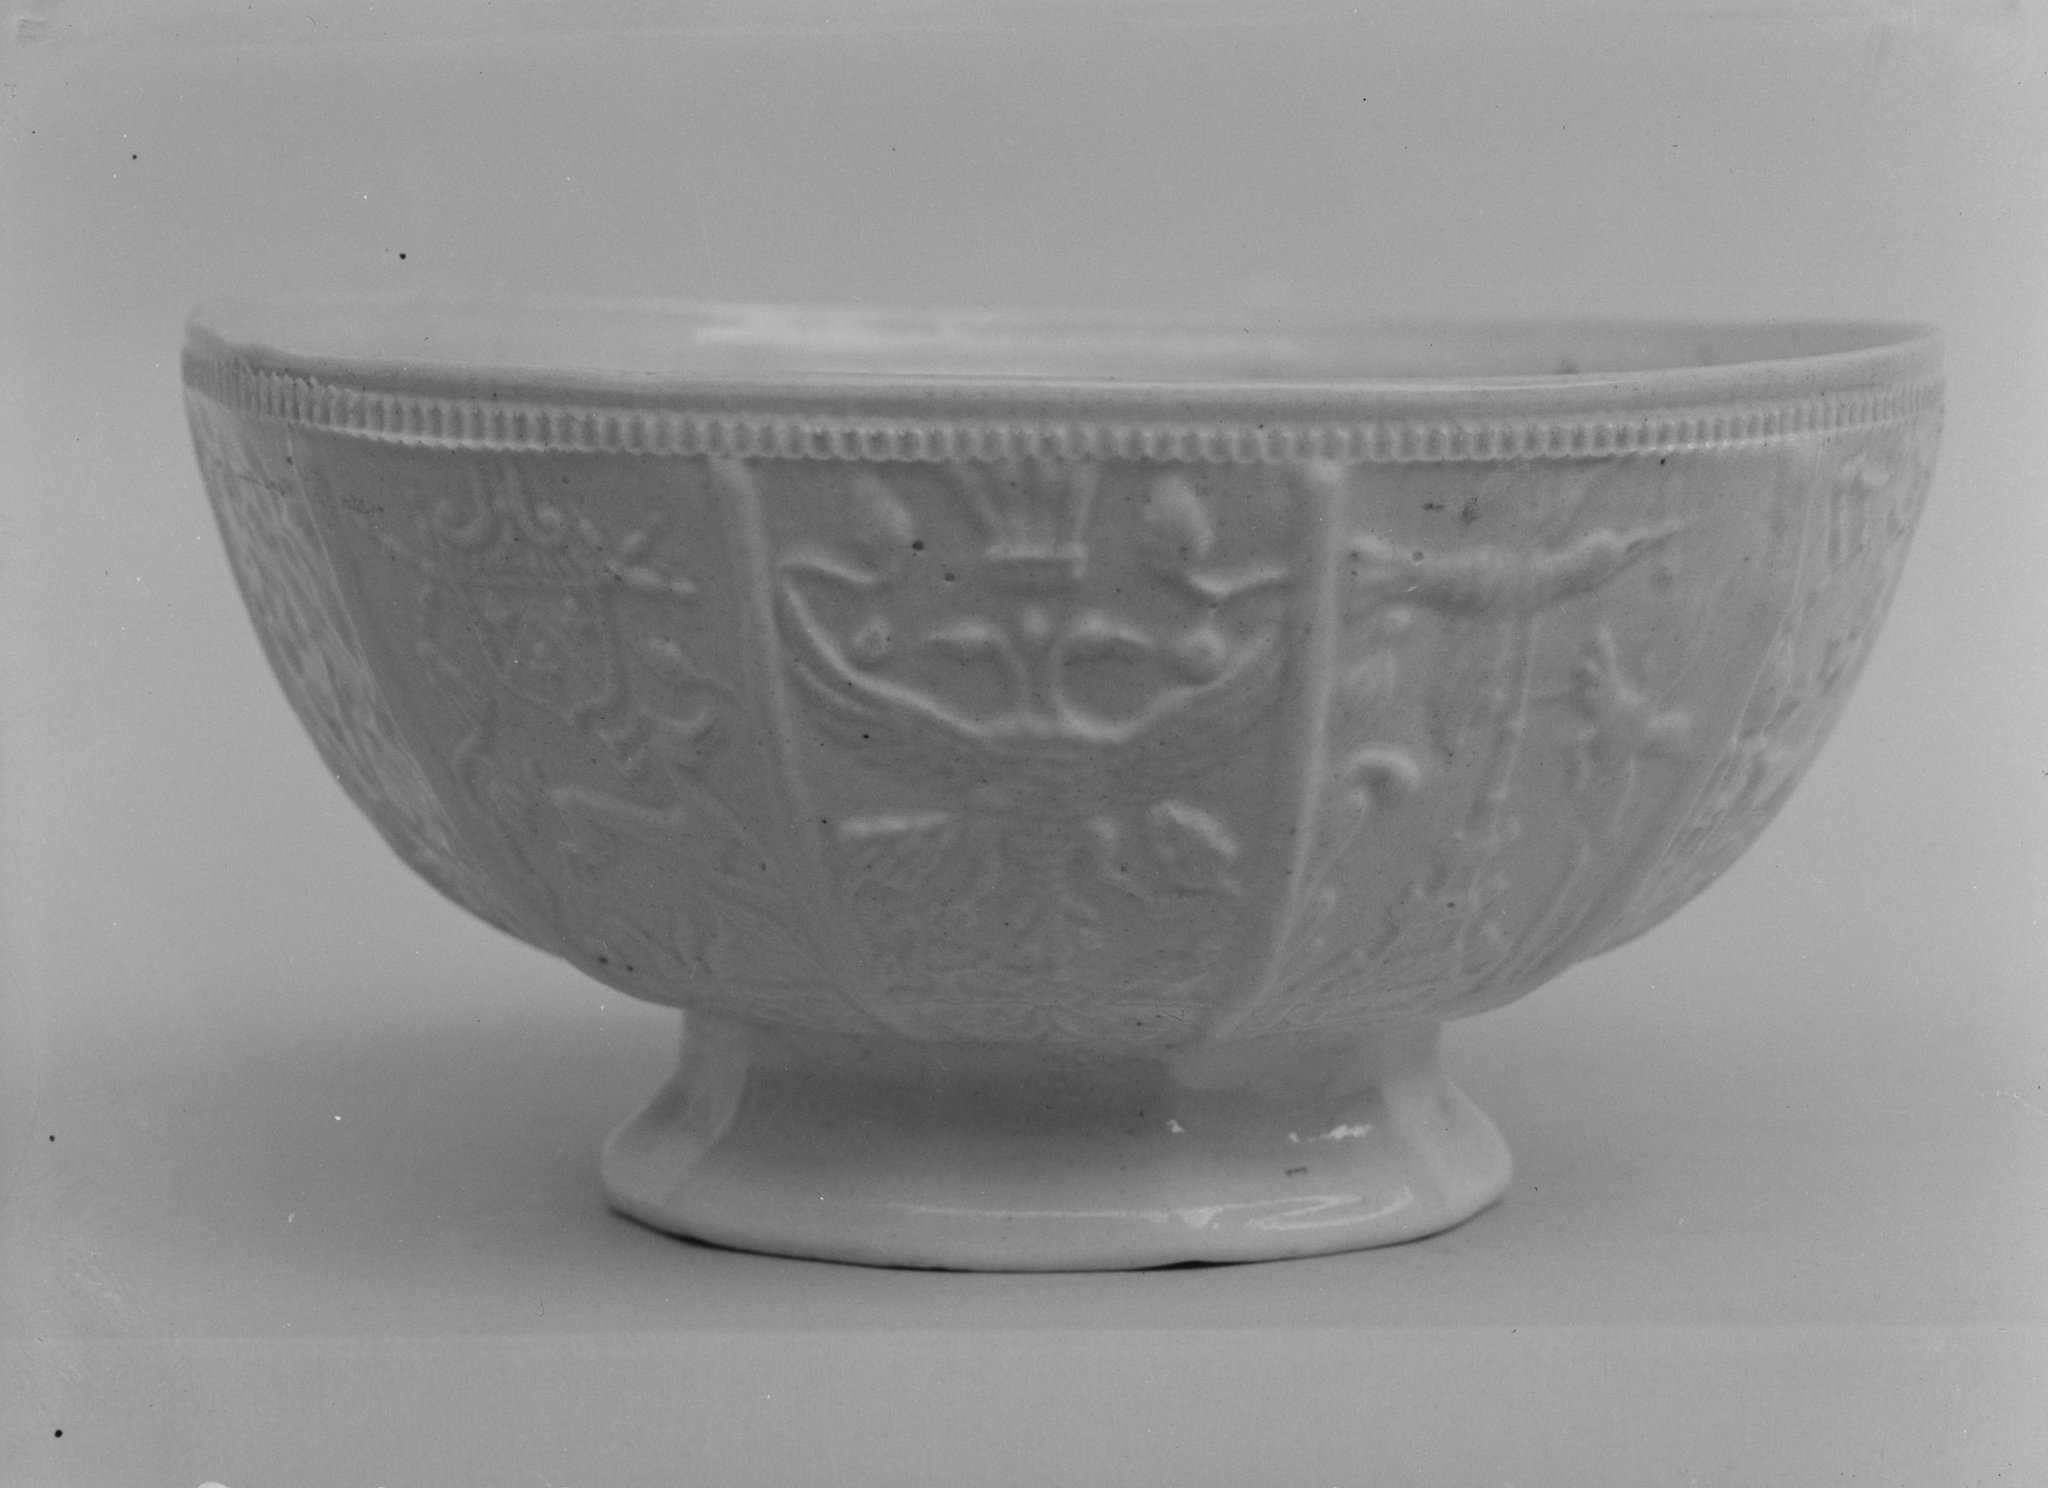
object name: bowl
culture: british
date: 1740-1750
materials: stoneware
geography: england